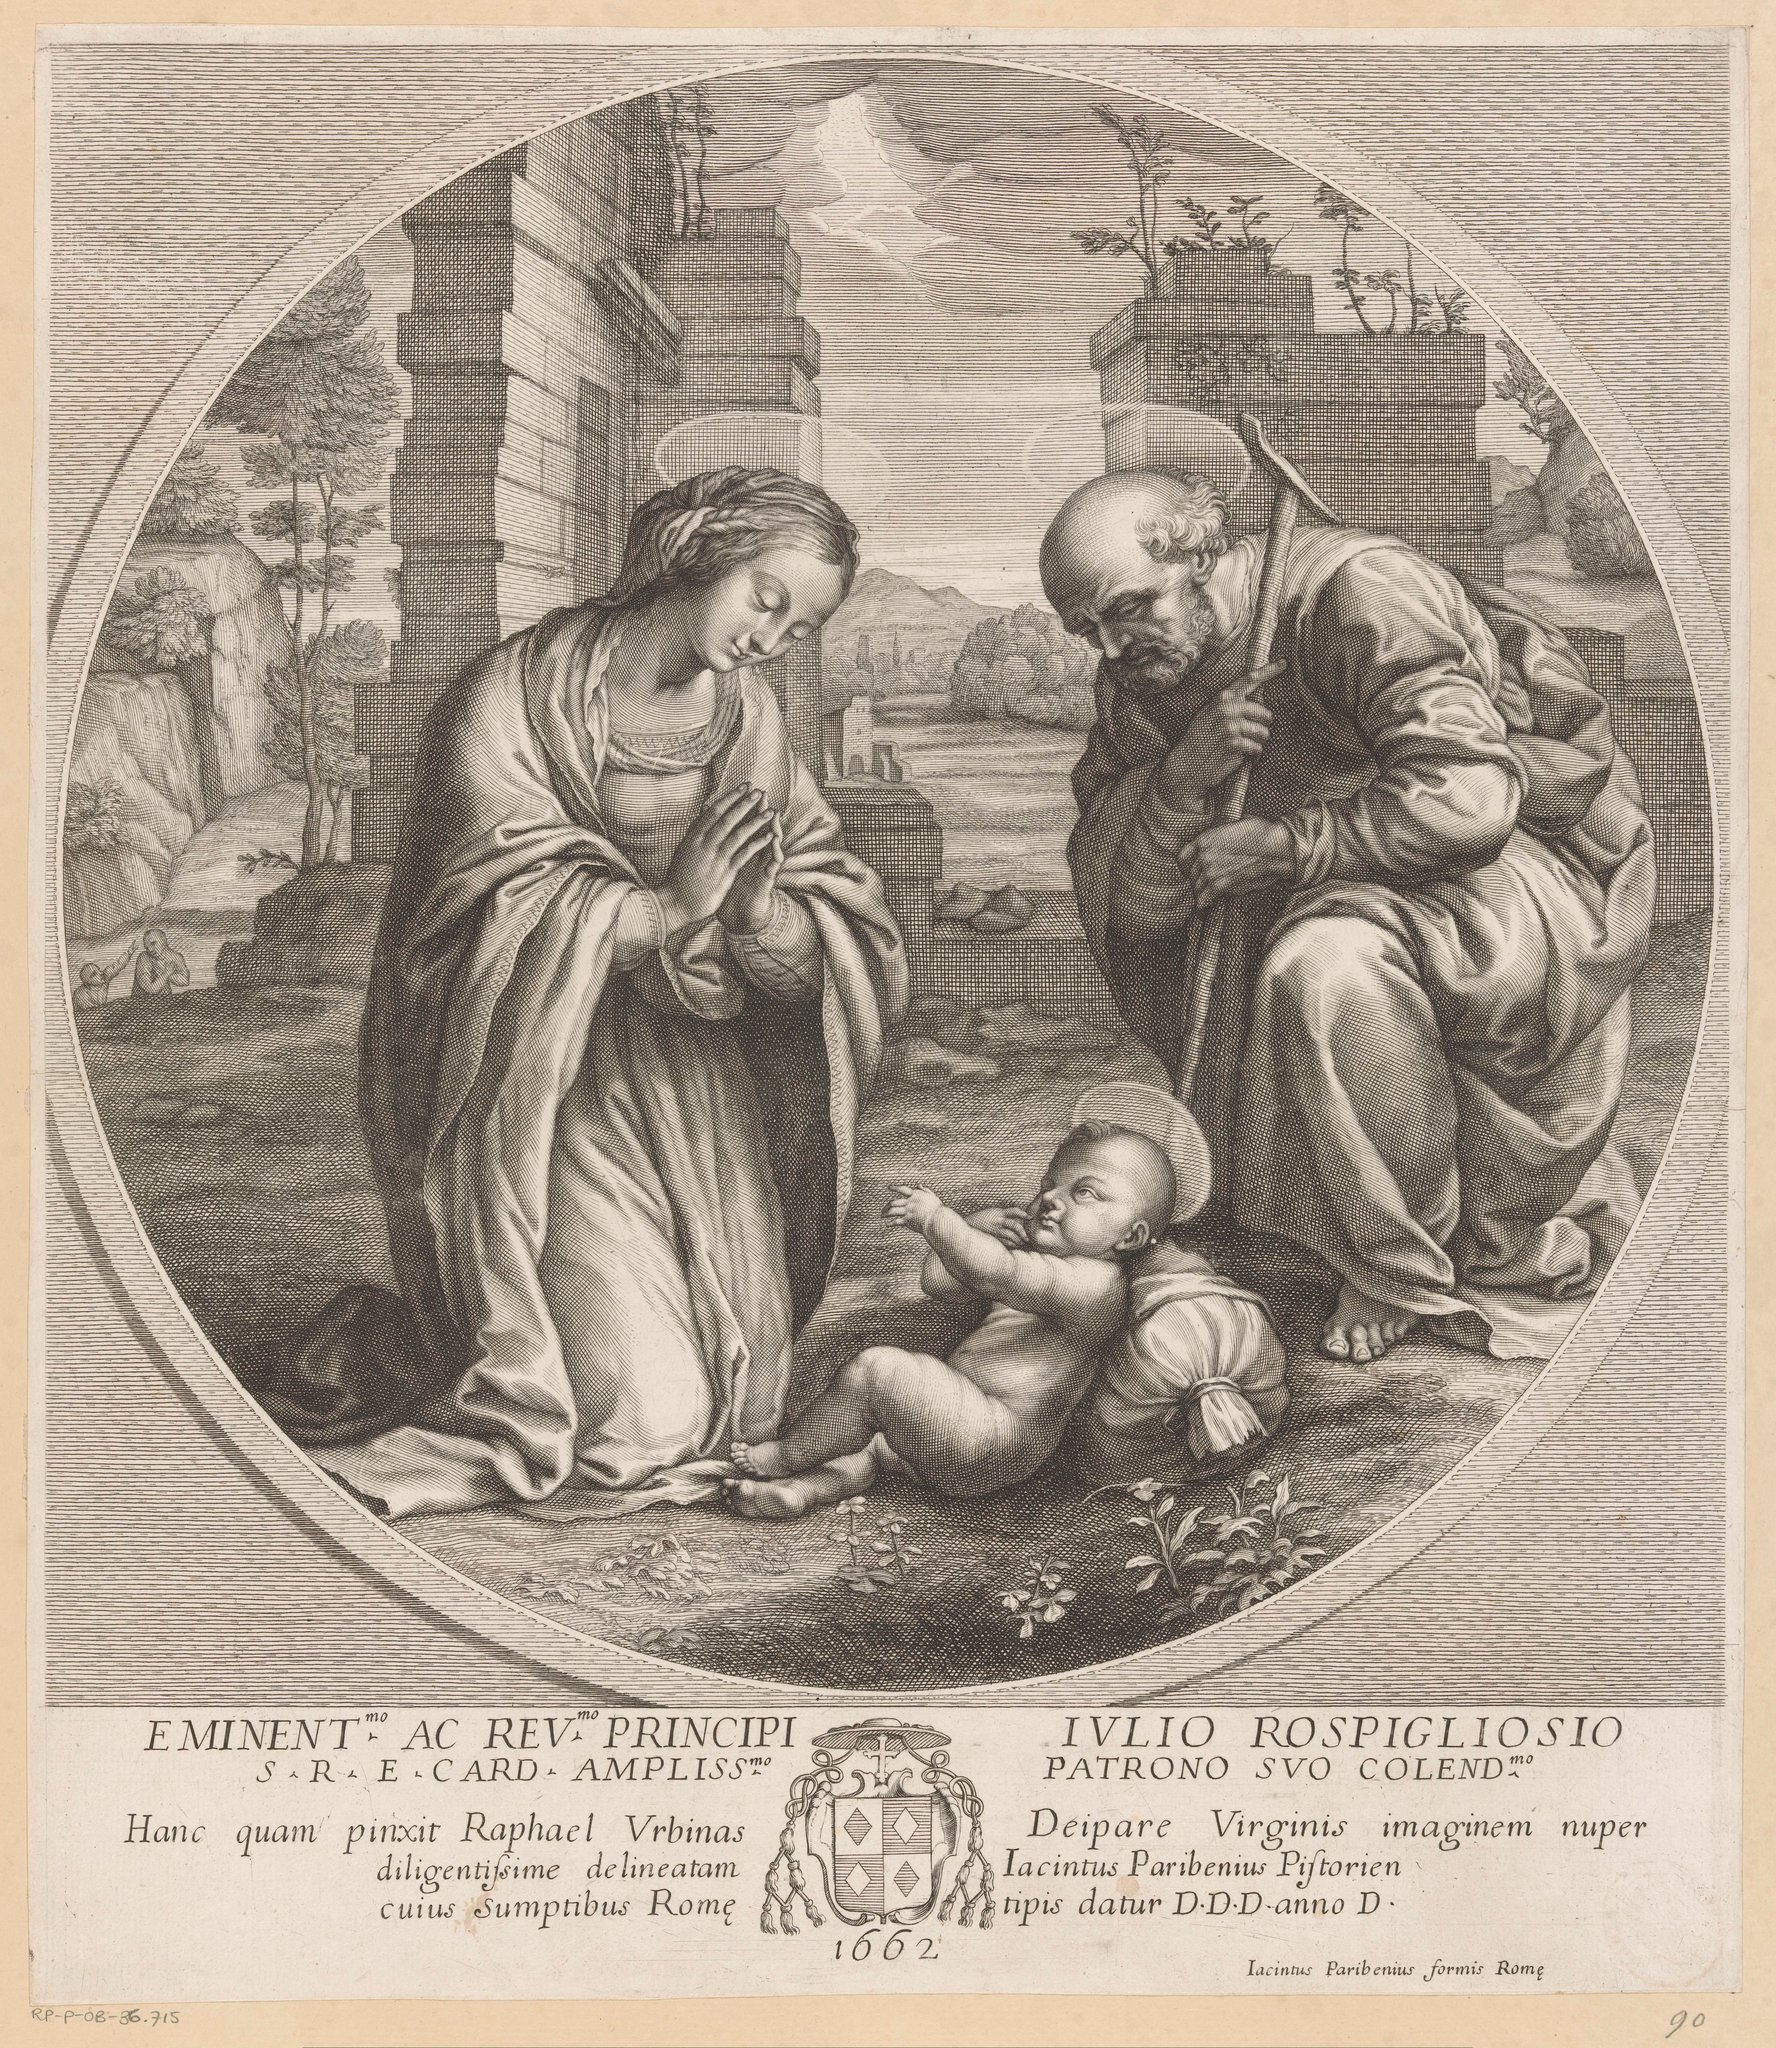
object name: print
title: Heilige Familie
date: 1662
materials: paper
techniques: engraving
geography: rome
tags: holy family, and derived representations, landscape with ruins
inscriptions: collector's mark: Lugt 240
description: Jozef en Maria knielen naast het Christuskind voor een ruïne in een landschap. Opdracht en kardinaalswapen in ondermarge.